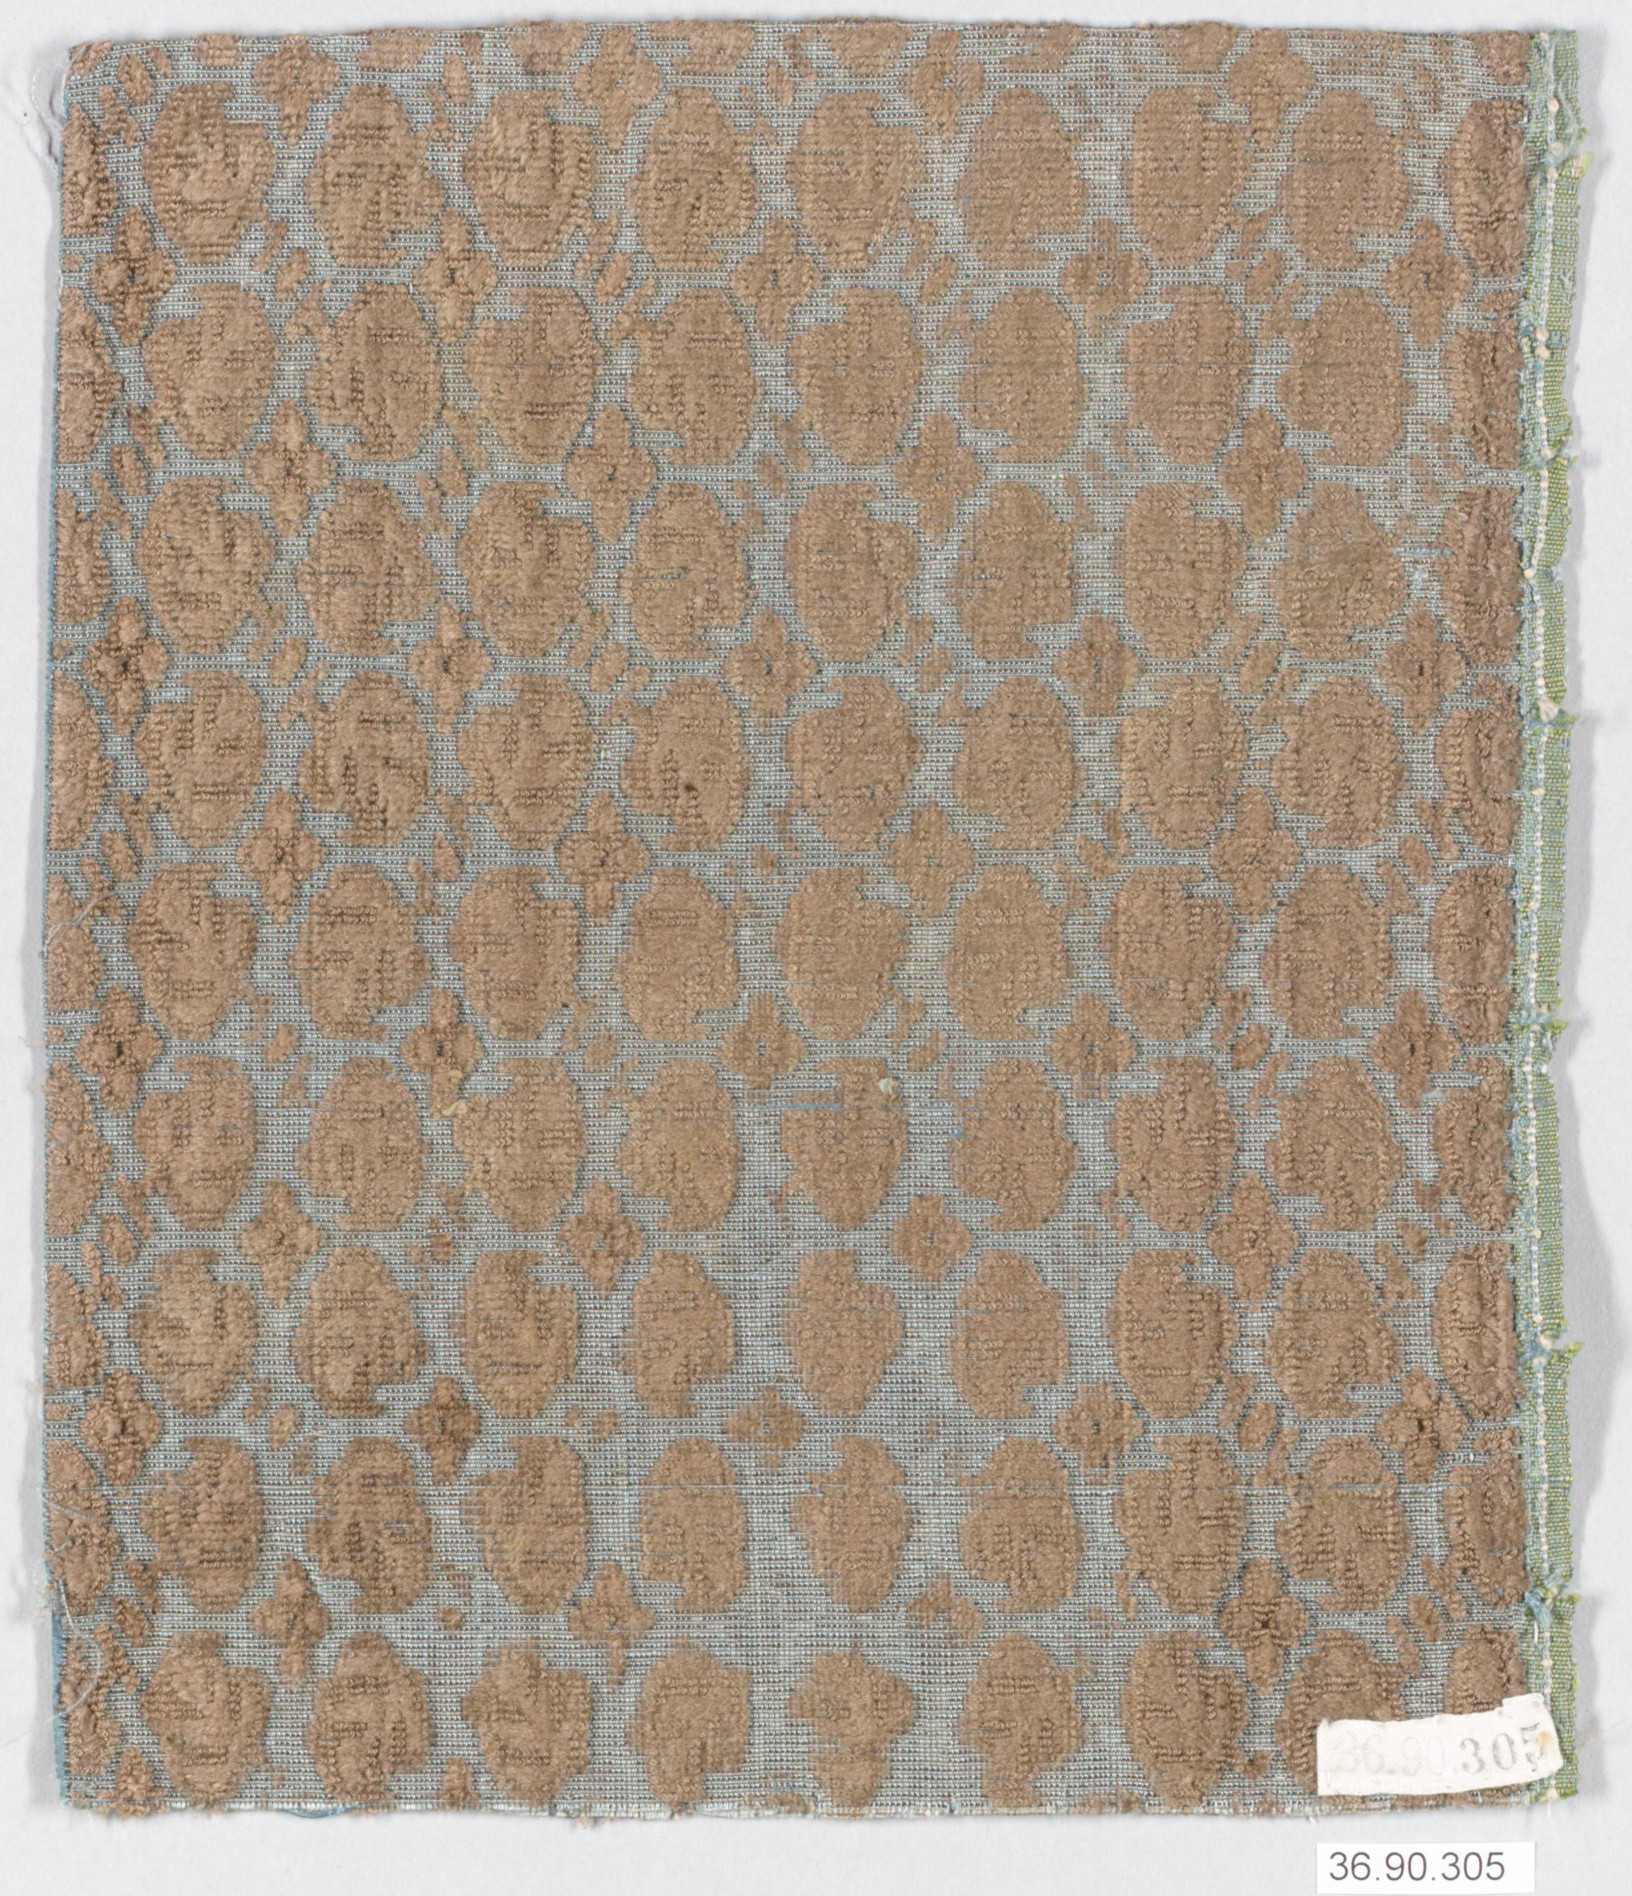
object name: piece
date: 1501-1700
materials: metal thread, silk